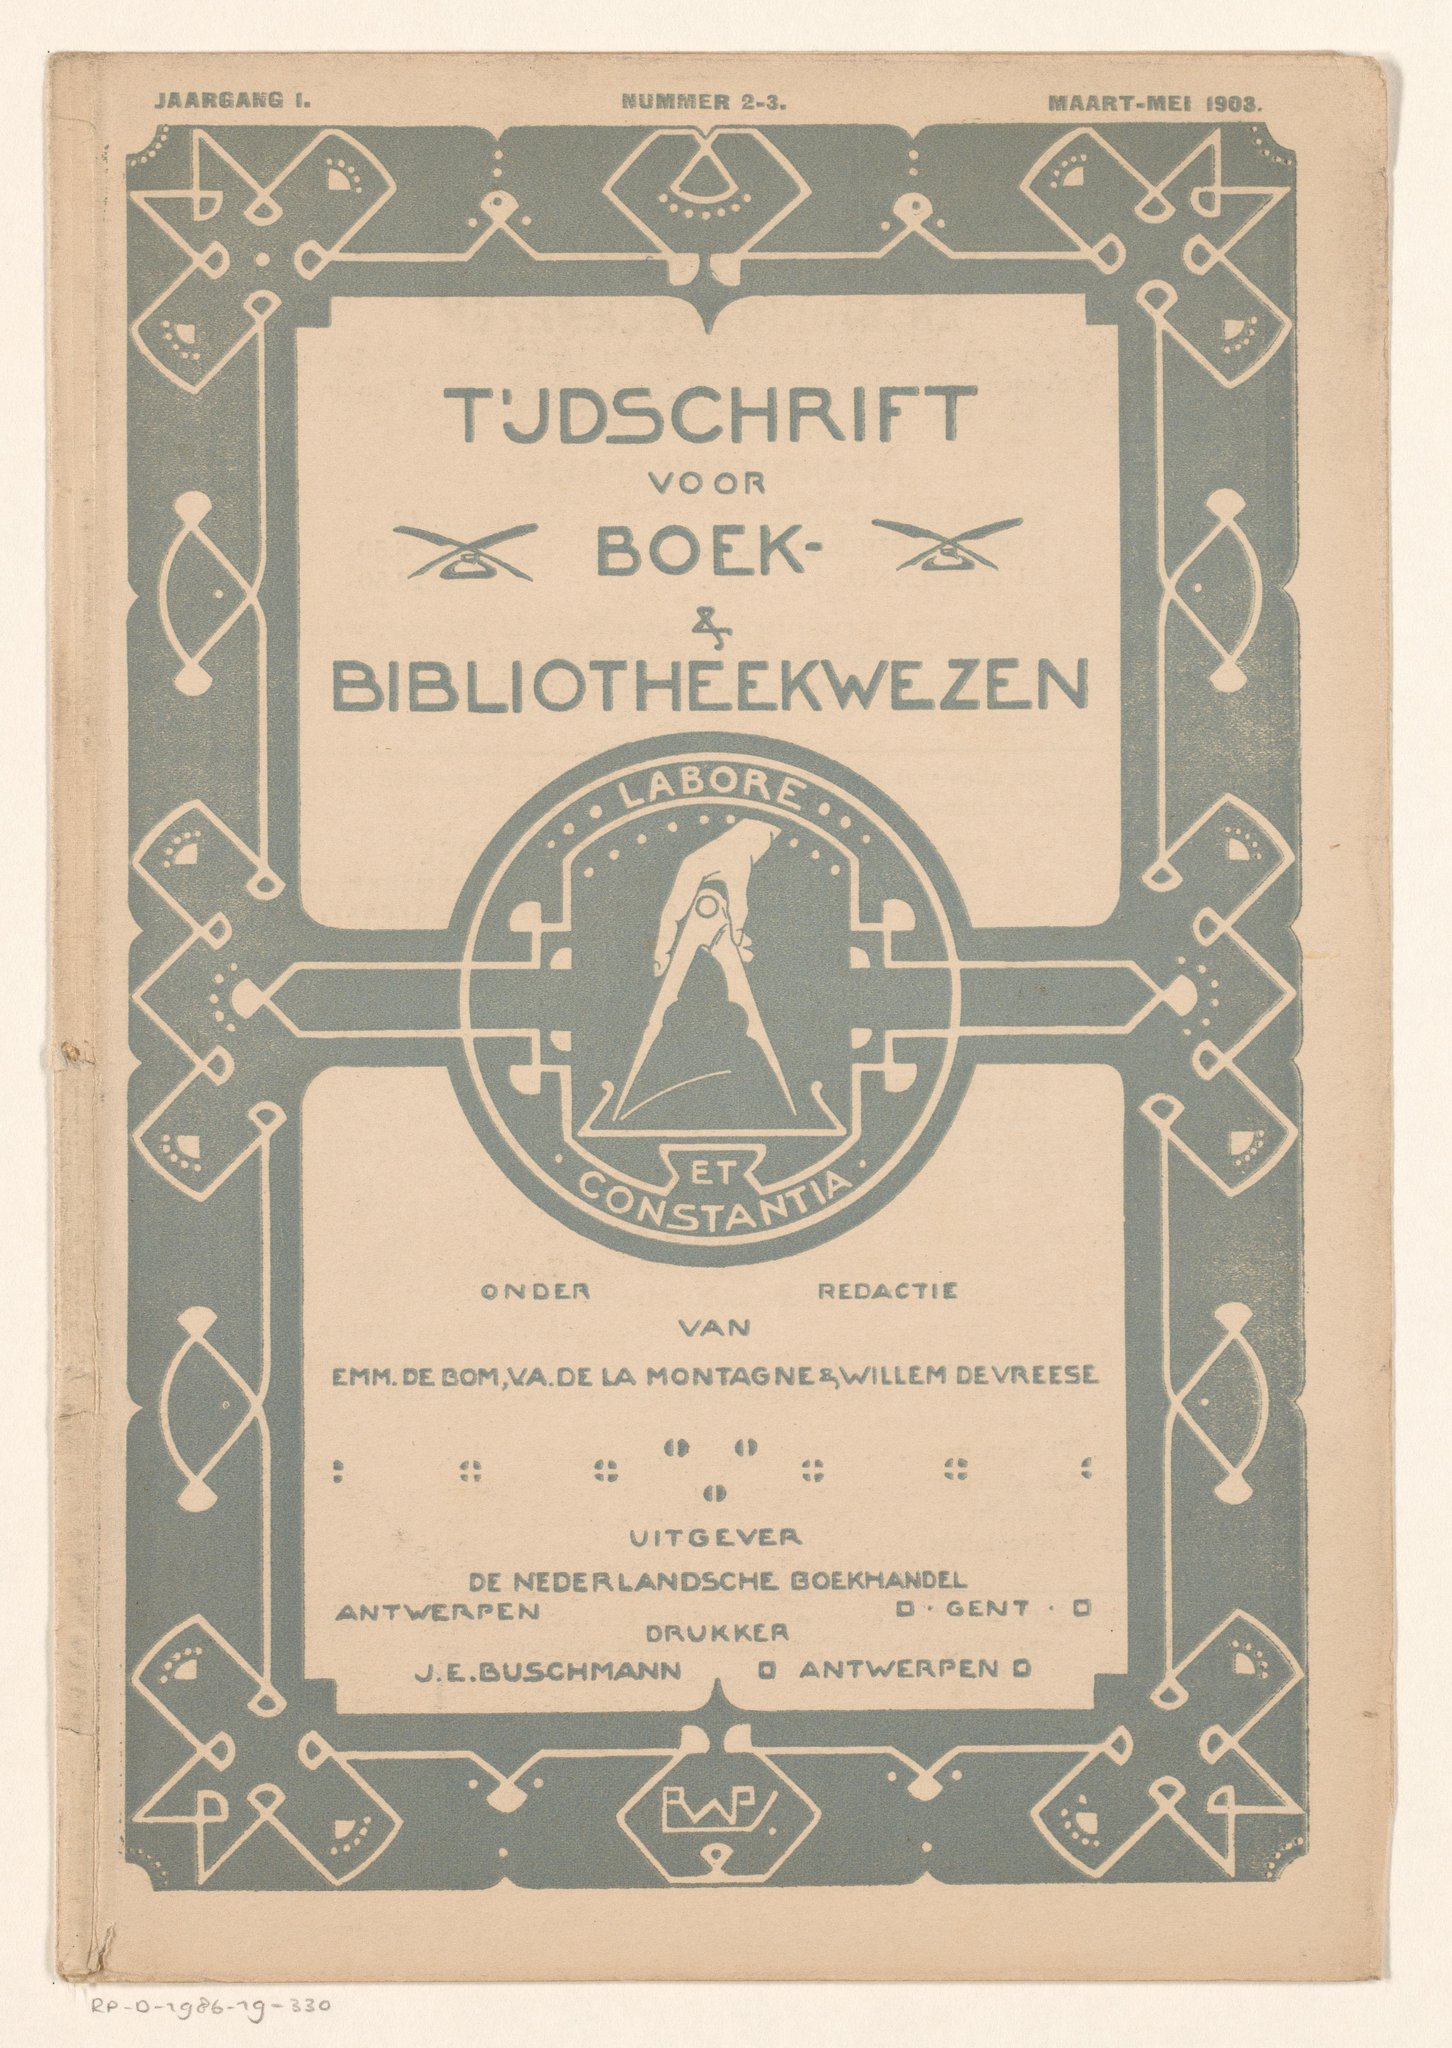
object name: photomechanical print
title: Omslag van: Tijdschrift voor boek- en bibliotheekwezen, maart-mei 1903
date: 1903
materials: paper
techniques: printing block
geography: antwerp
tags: compasses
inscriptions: collector's mark: ‘BIBLIOTHEEK/ VEREENIGING TER BEVORDERING VAN DE BELANGEN DES BOEKHANDELS’, collector's mark: ‘R:MVS.’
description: Ornamenteel kader met in het midden een cirkel met een hand met een passer en het motto 'Labore et Constantia'.